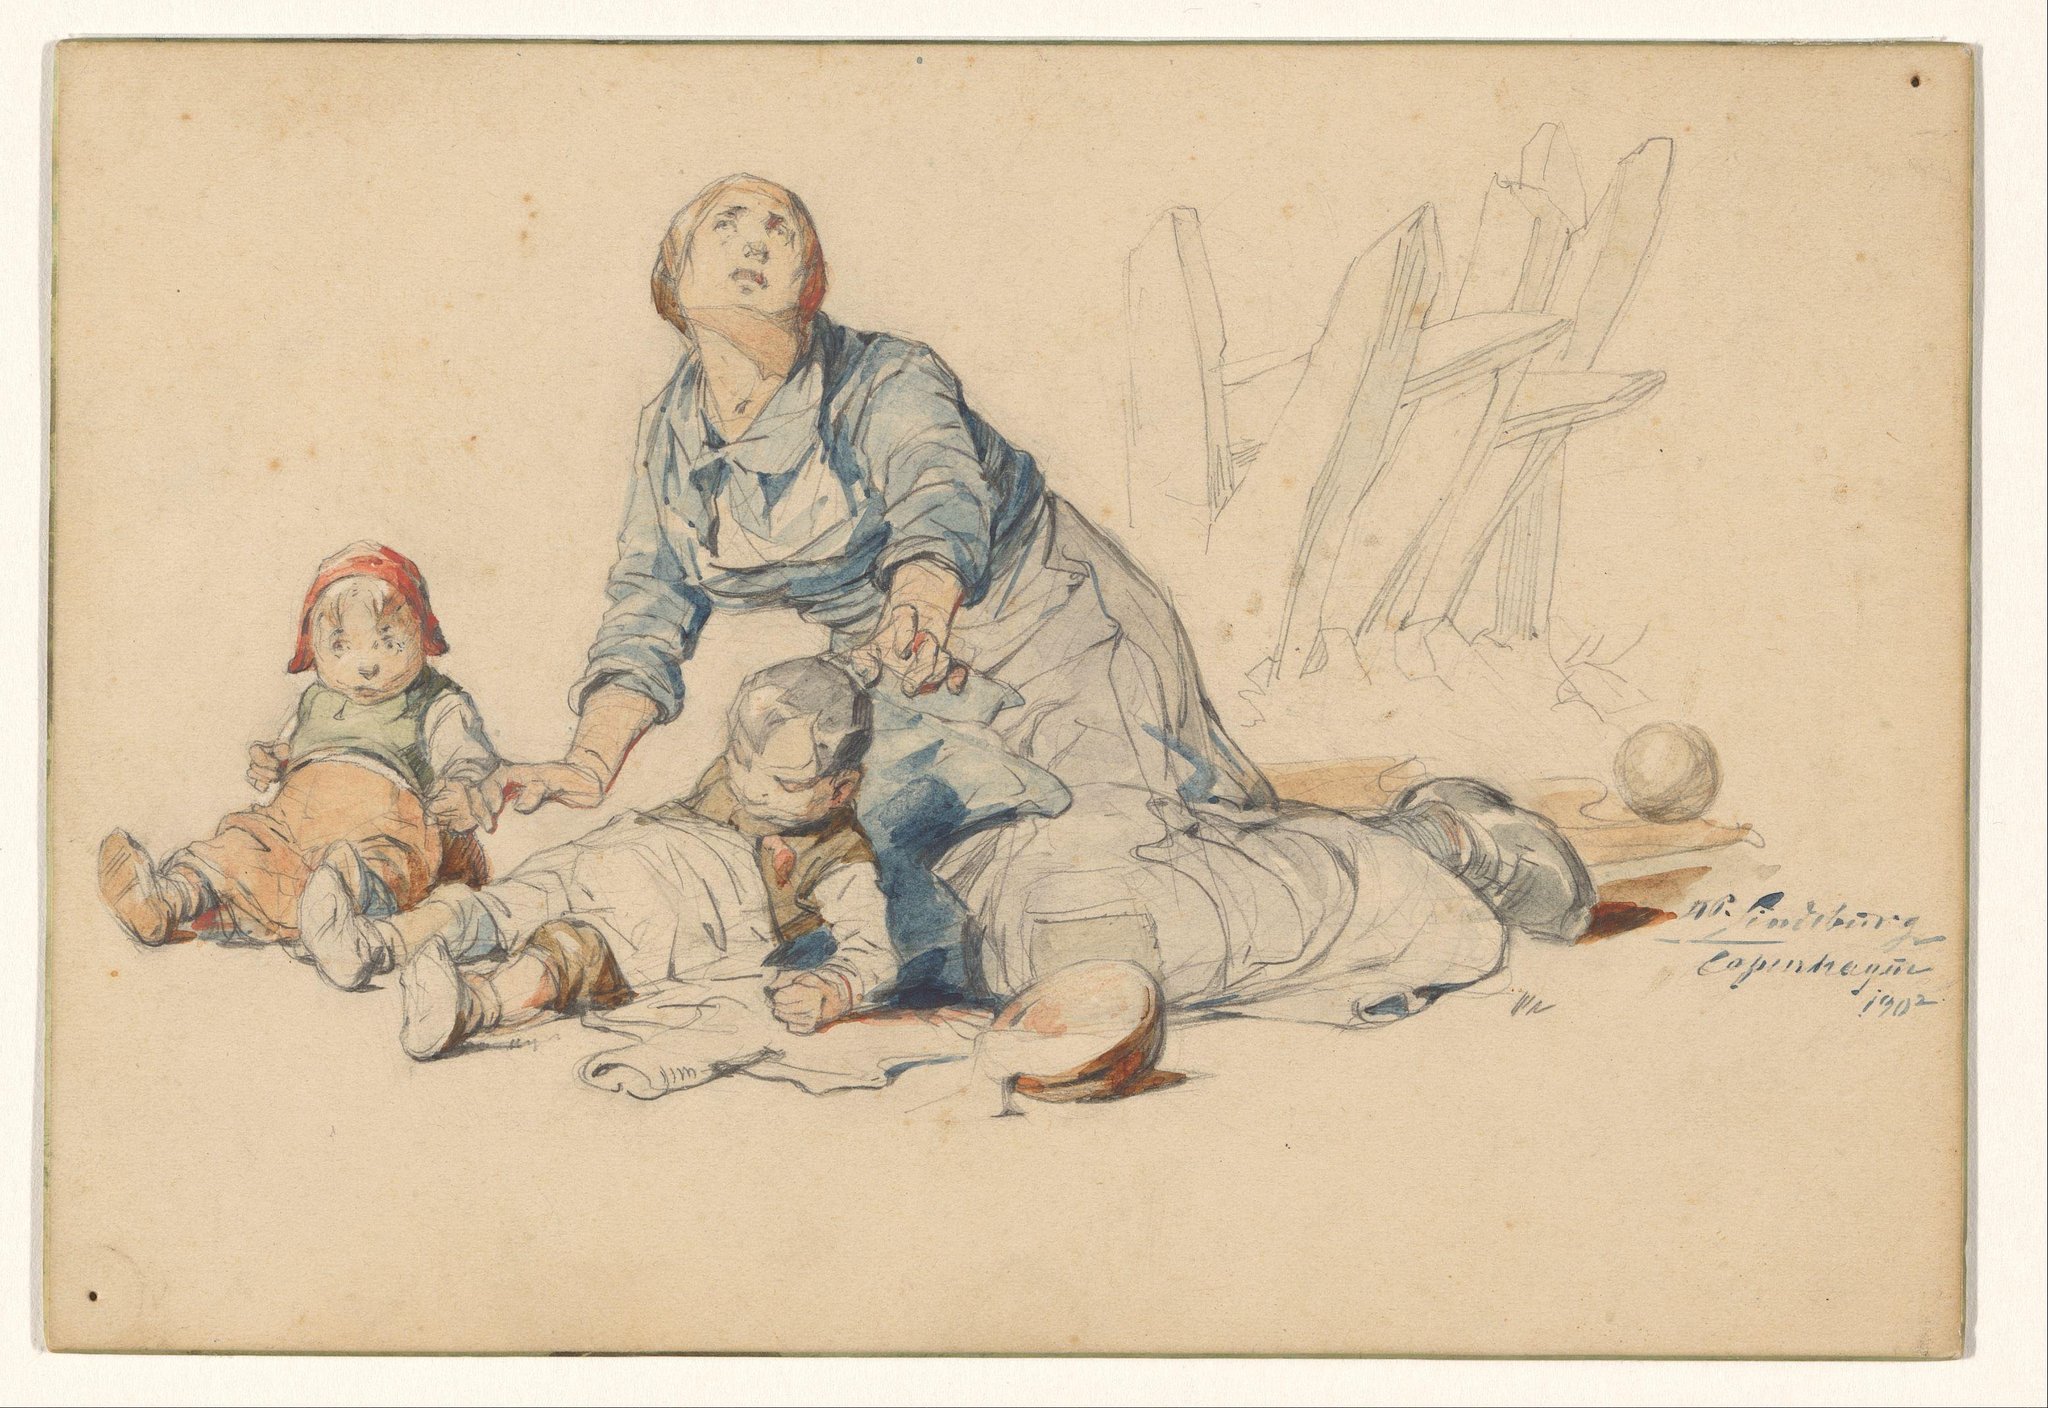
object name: drawing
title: Vrouw met twee zieke of uitgehongerde kinderen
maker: hans peter lindeburg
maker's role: draughtsman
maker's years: 1854-1932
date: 1902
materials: cardboard, pencil, watercolor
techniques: brush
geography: copenhagen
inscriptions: date